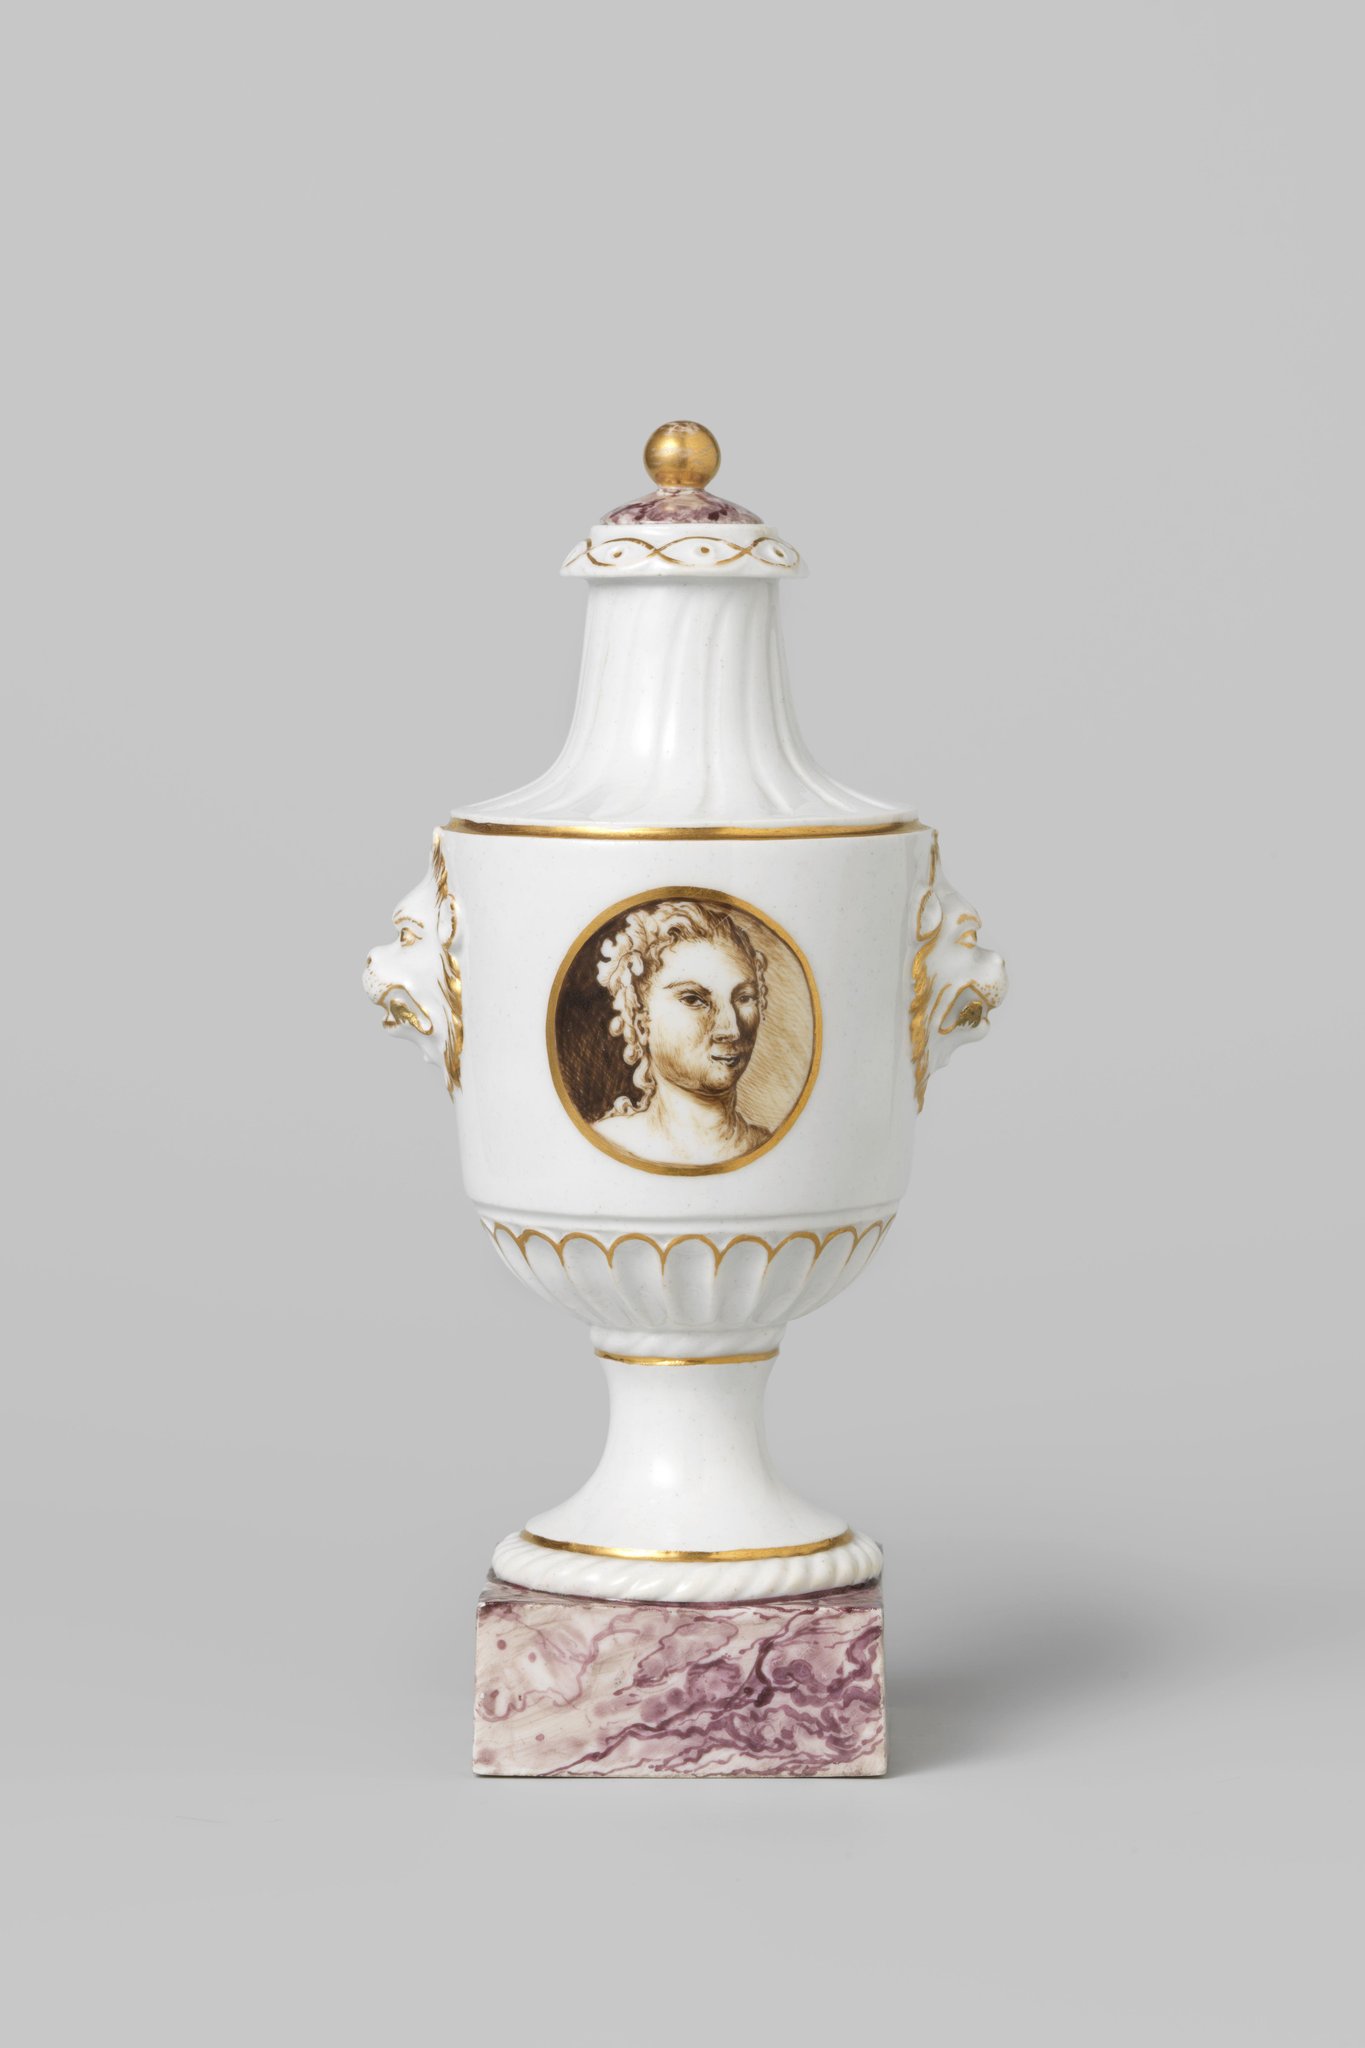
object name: lid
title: Deksel van vaas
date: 1774-1784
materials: porcelain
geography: loosdrecht